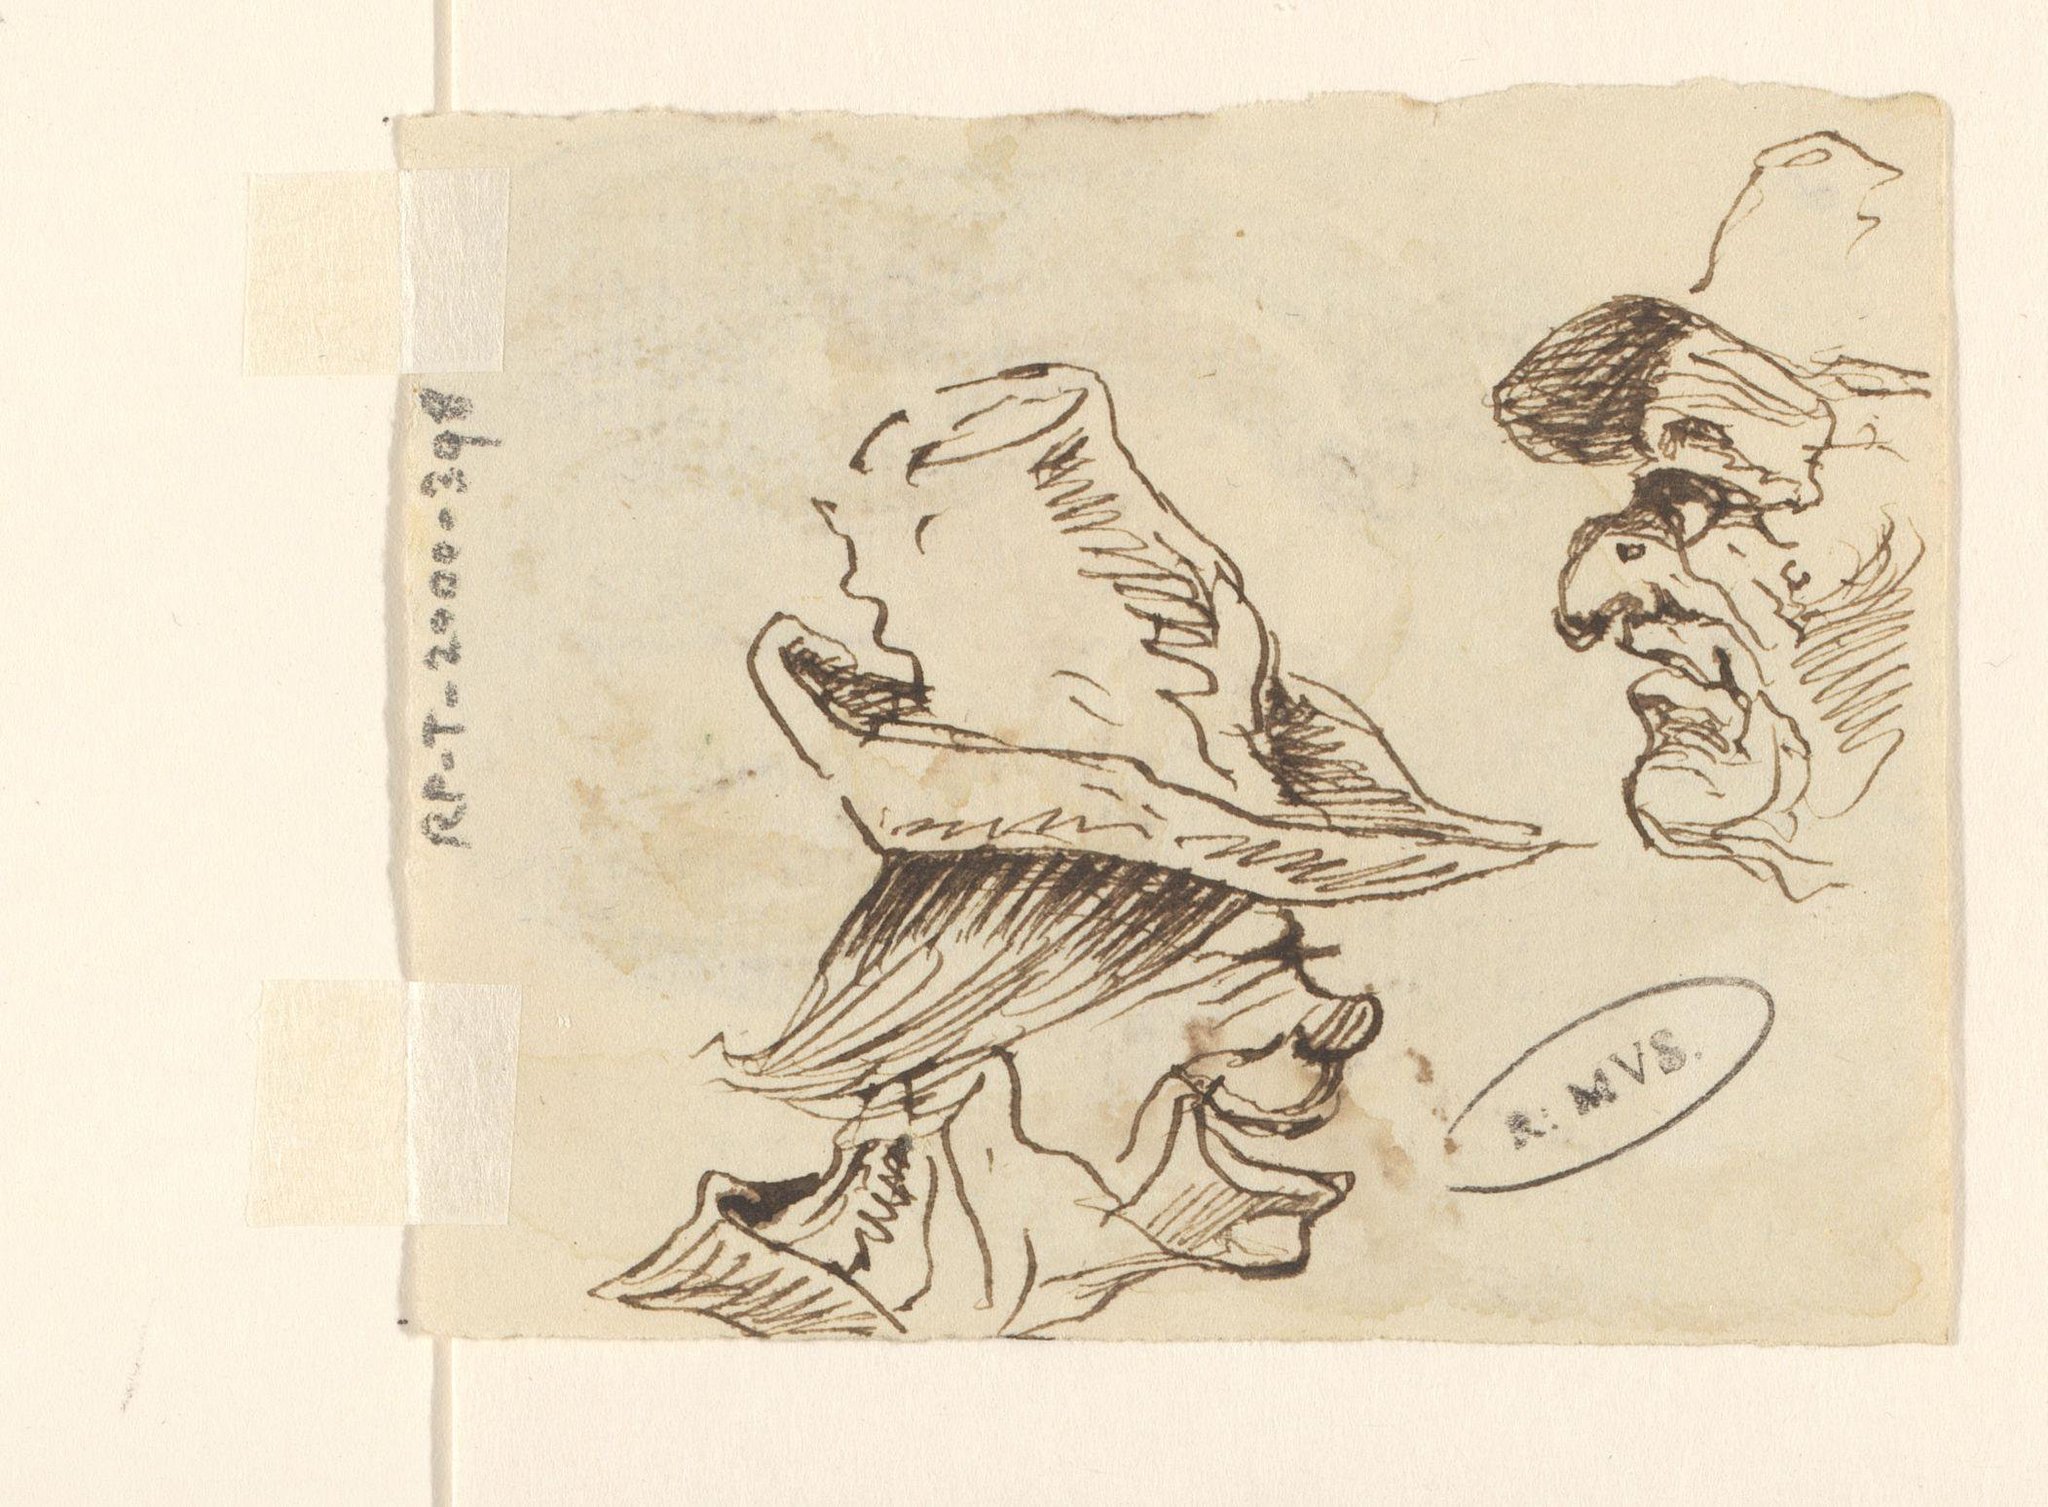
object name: drawing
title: Twee koppen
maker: johannes tavenraat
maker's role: draughtsman, painter, print maker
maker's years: 1809-1881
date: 1870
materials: ink, paper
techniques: pen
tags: caricatures (human types)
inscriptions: collector's mark: Lugt 2228